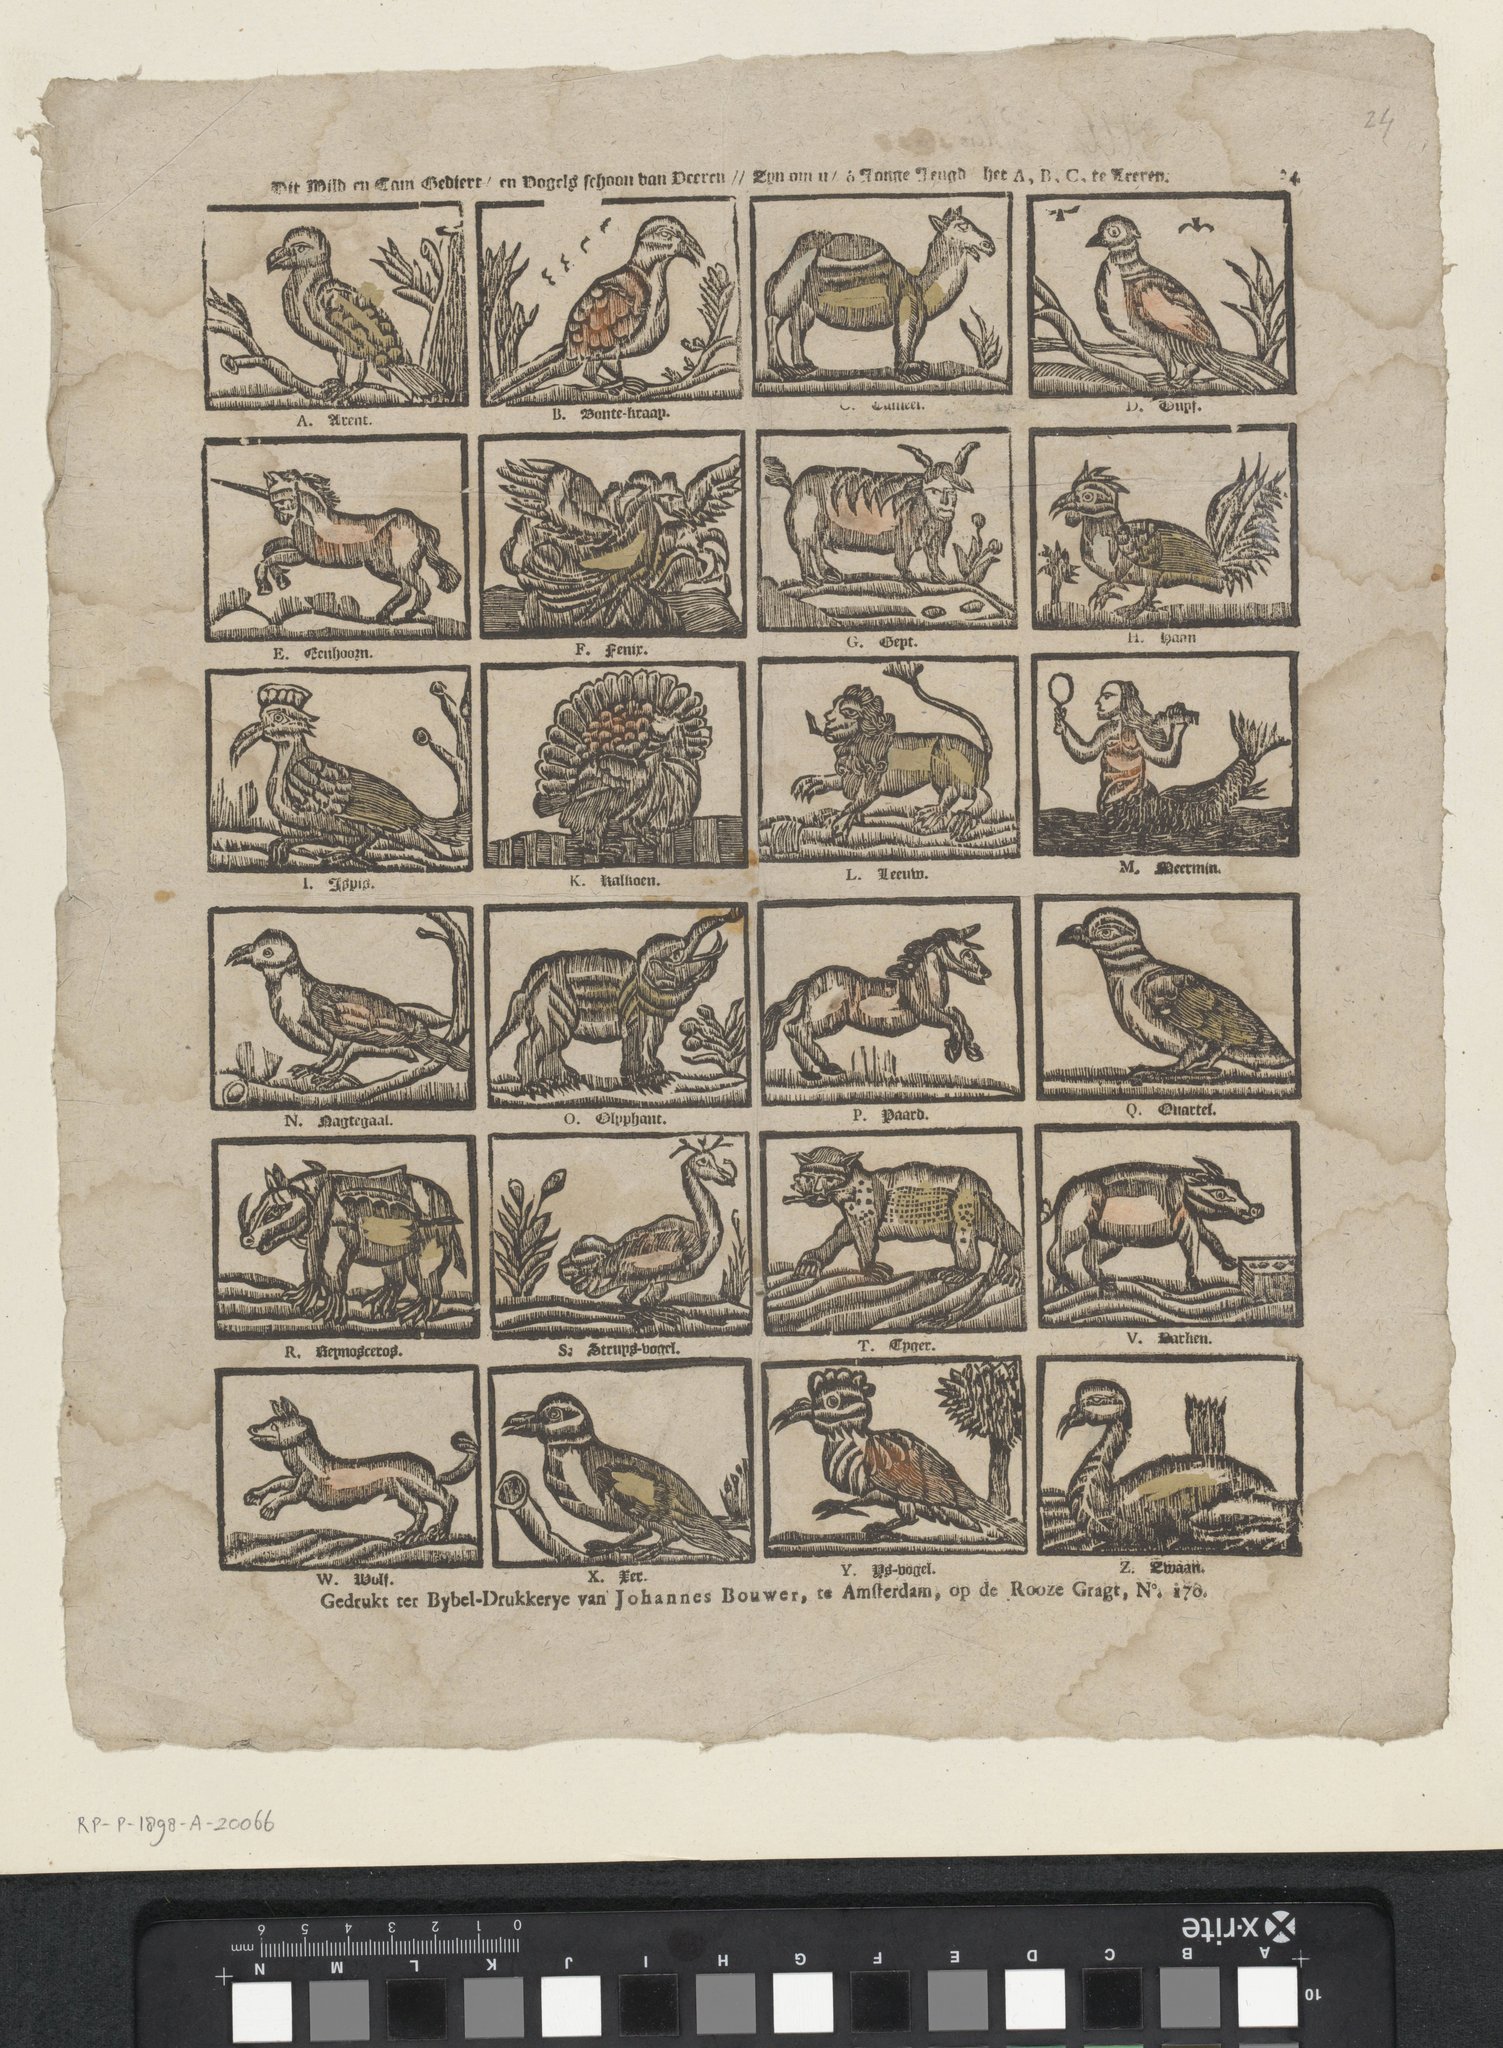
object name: popular print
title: Dit wild en tam gediert / en vogels schoon van veeren // Zijn om u / ô jonge jeugd / het A, B, C, te leeren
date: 1805-1808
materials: paper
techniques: colour, letterpress printing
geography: amsterdam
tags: fabulous animals (sometimes wrongly called 'grotesques'); 'mostri' (ripa), animals, letters, alphabet, script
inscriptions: collector's mark: Lugt 2228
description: Blad met 24 voorstellingen voorstellingen van de letters van het alfabet geïllustreerd met dieren waarvan de namen met de betreffende letter beginnen. Onder elke afbeelding een onderschrift. Genummerd rechtsboven: 24.